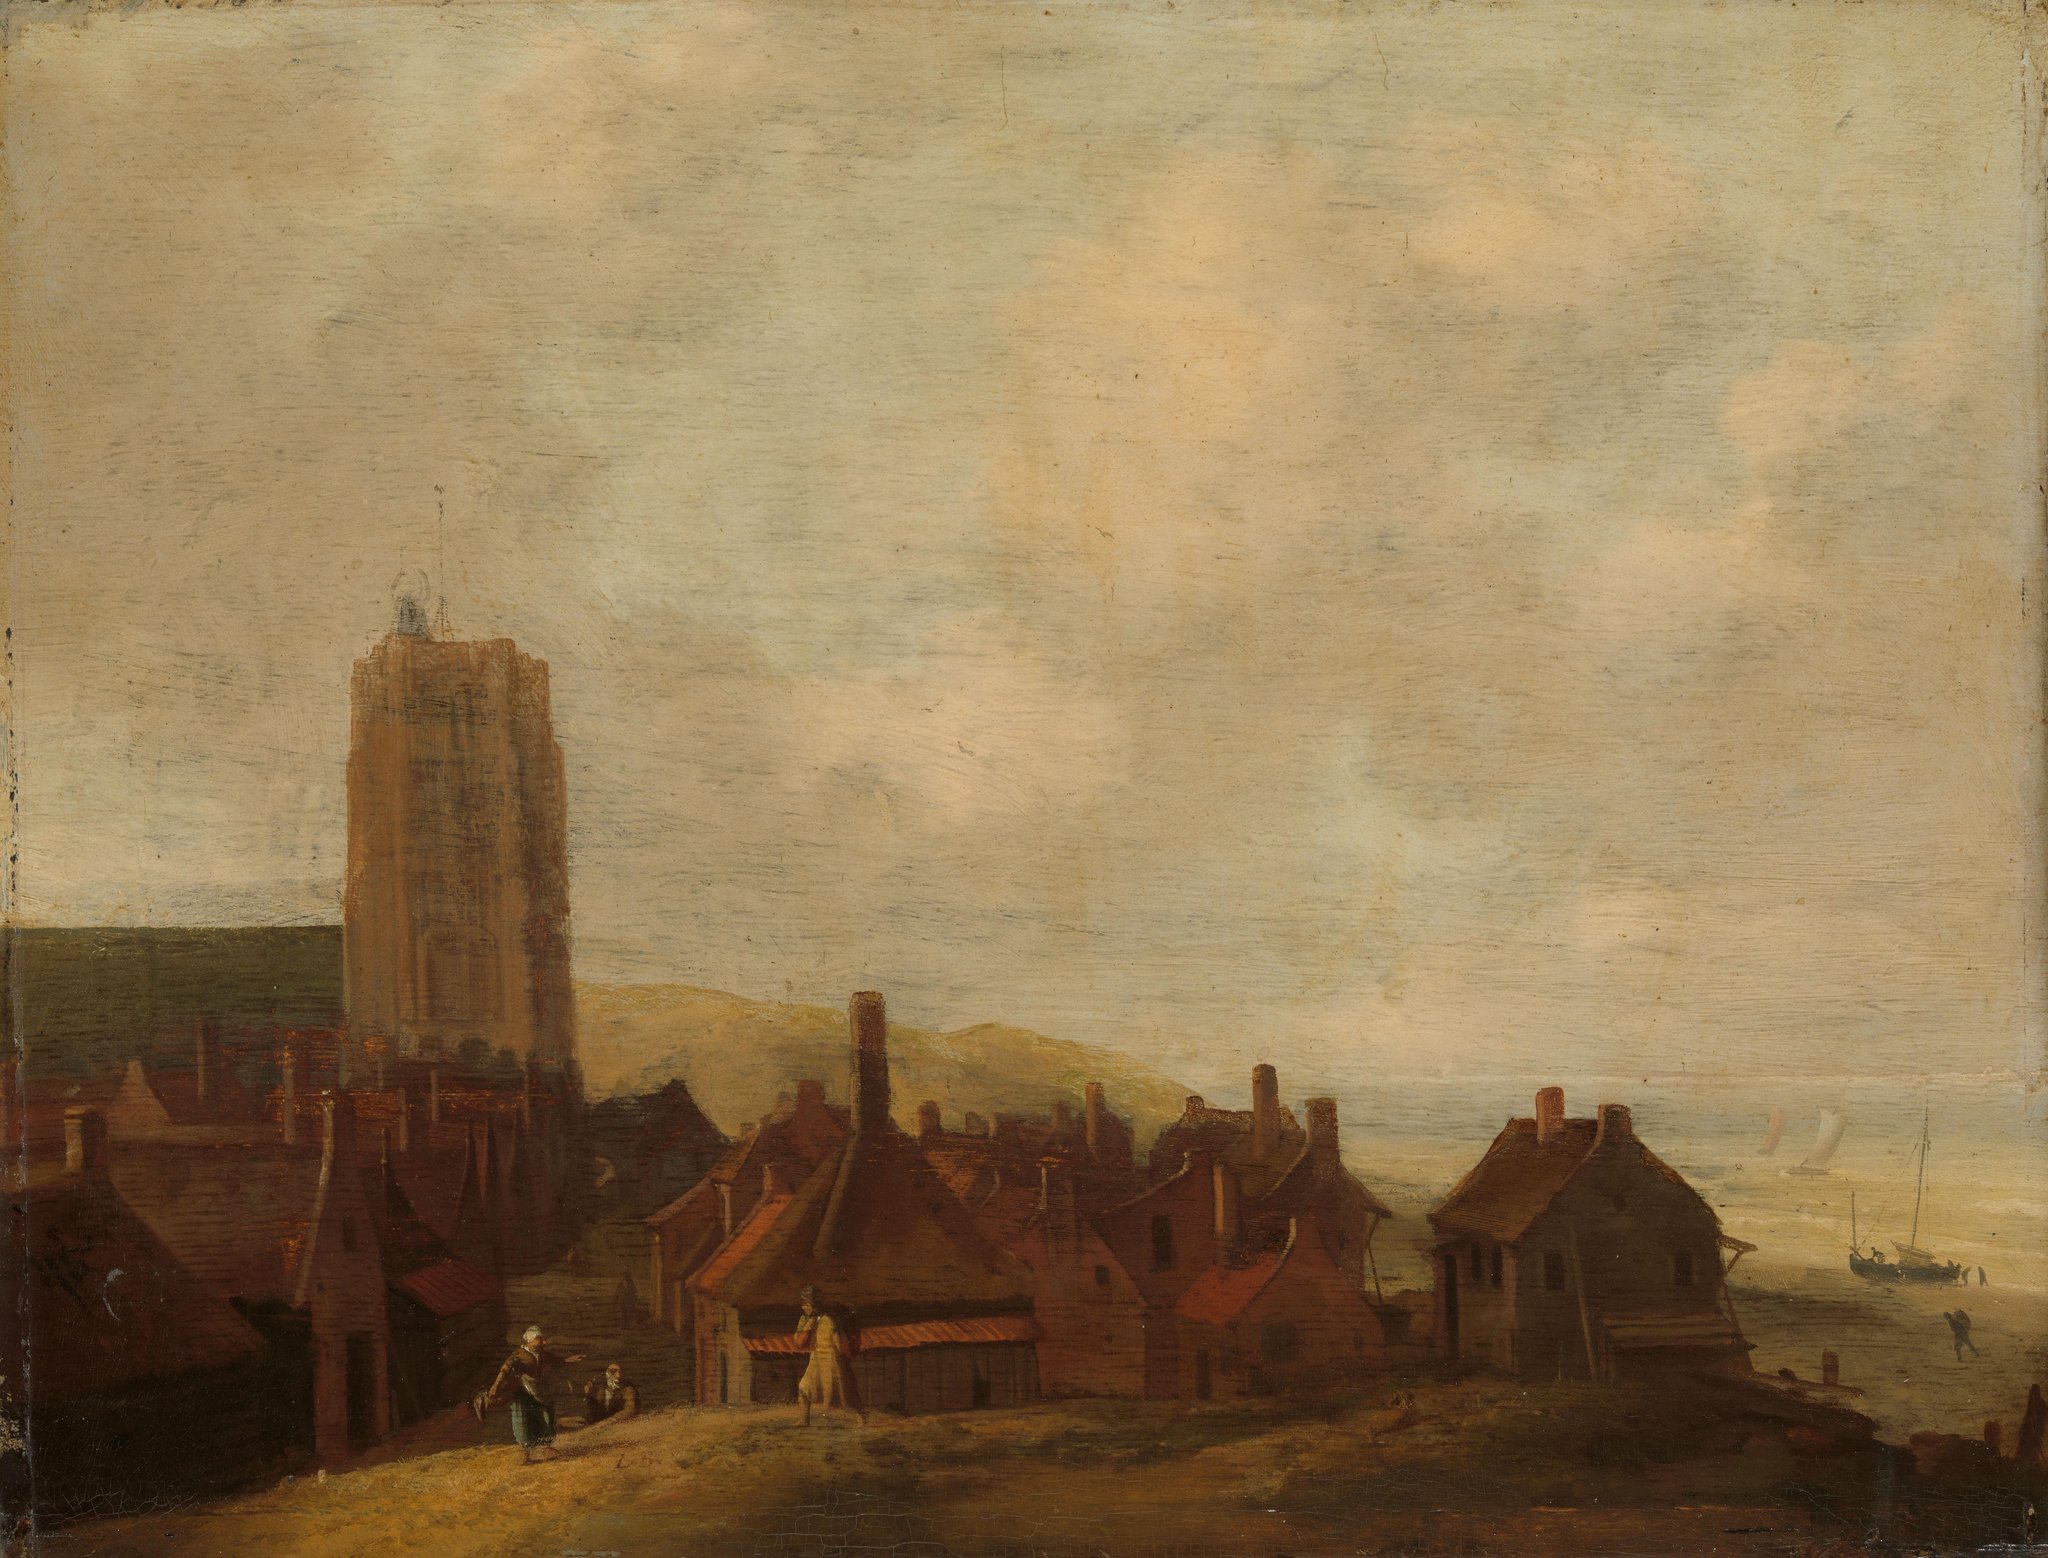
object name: painting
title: View of Egmond aan Zee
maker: ludolf bakhuysen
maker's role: draughtsman, print maker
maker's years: 1631-1708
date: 1660-1708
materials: oil, panel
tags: dune coast, church (exterior), prospect of city, town panorama, silhouette of city (+ city(-scape) with figures, staffage)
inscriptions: signature: ‘L.B.’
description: Gezicht op het dorp Egmond aan Zee. Op de voorgrond duinen, rechts de zee.